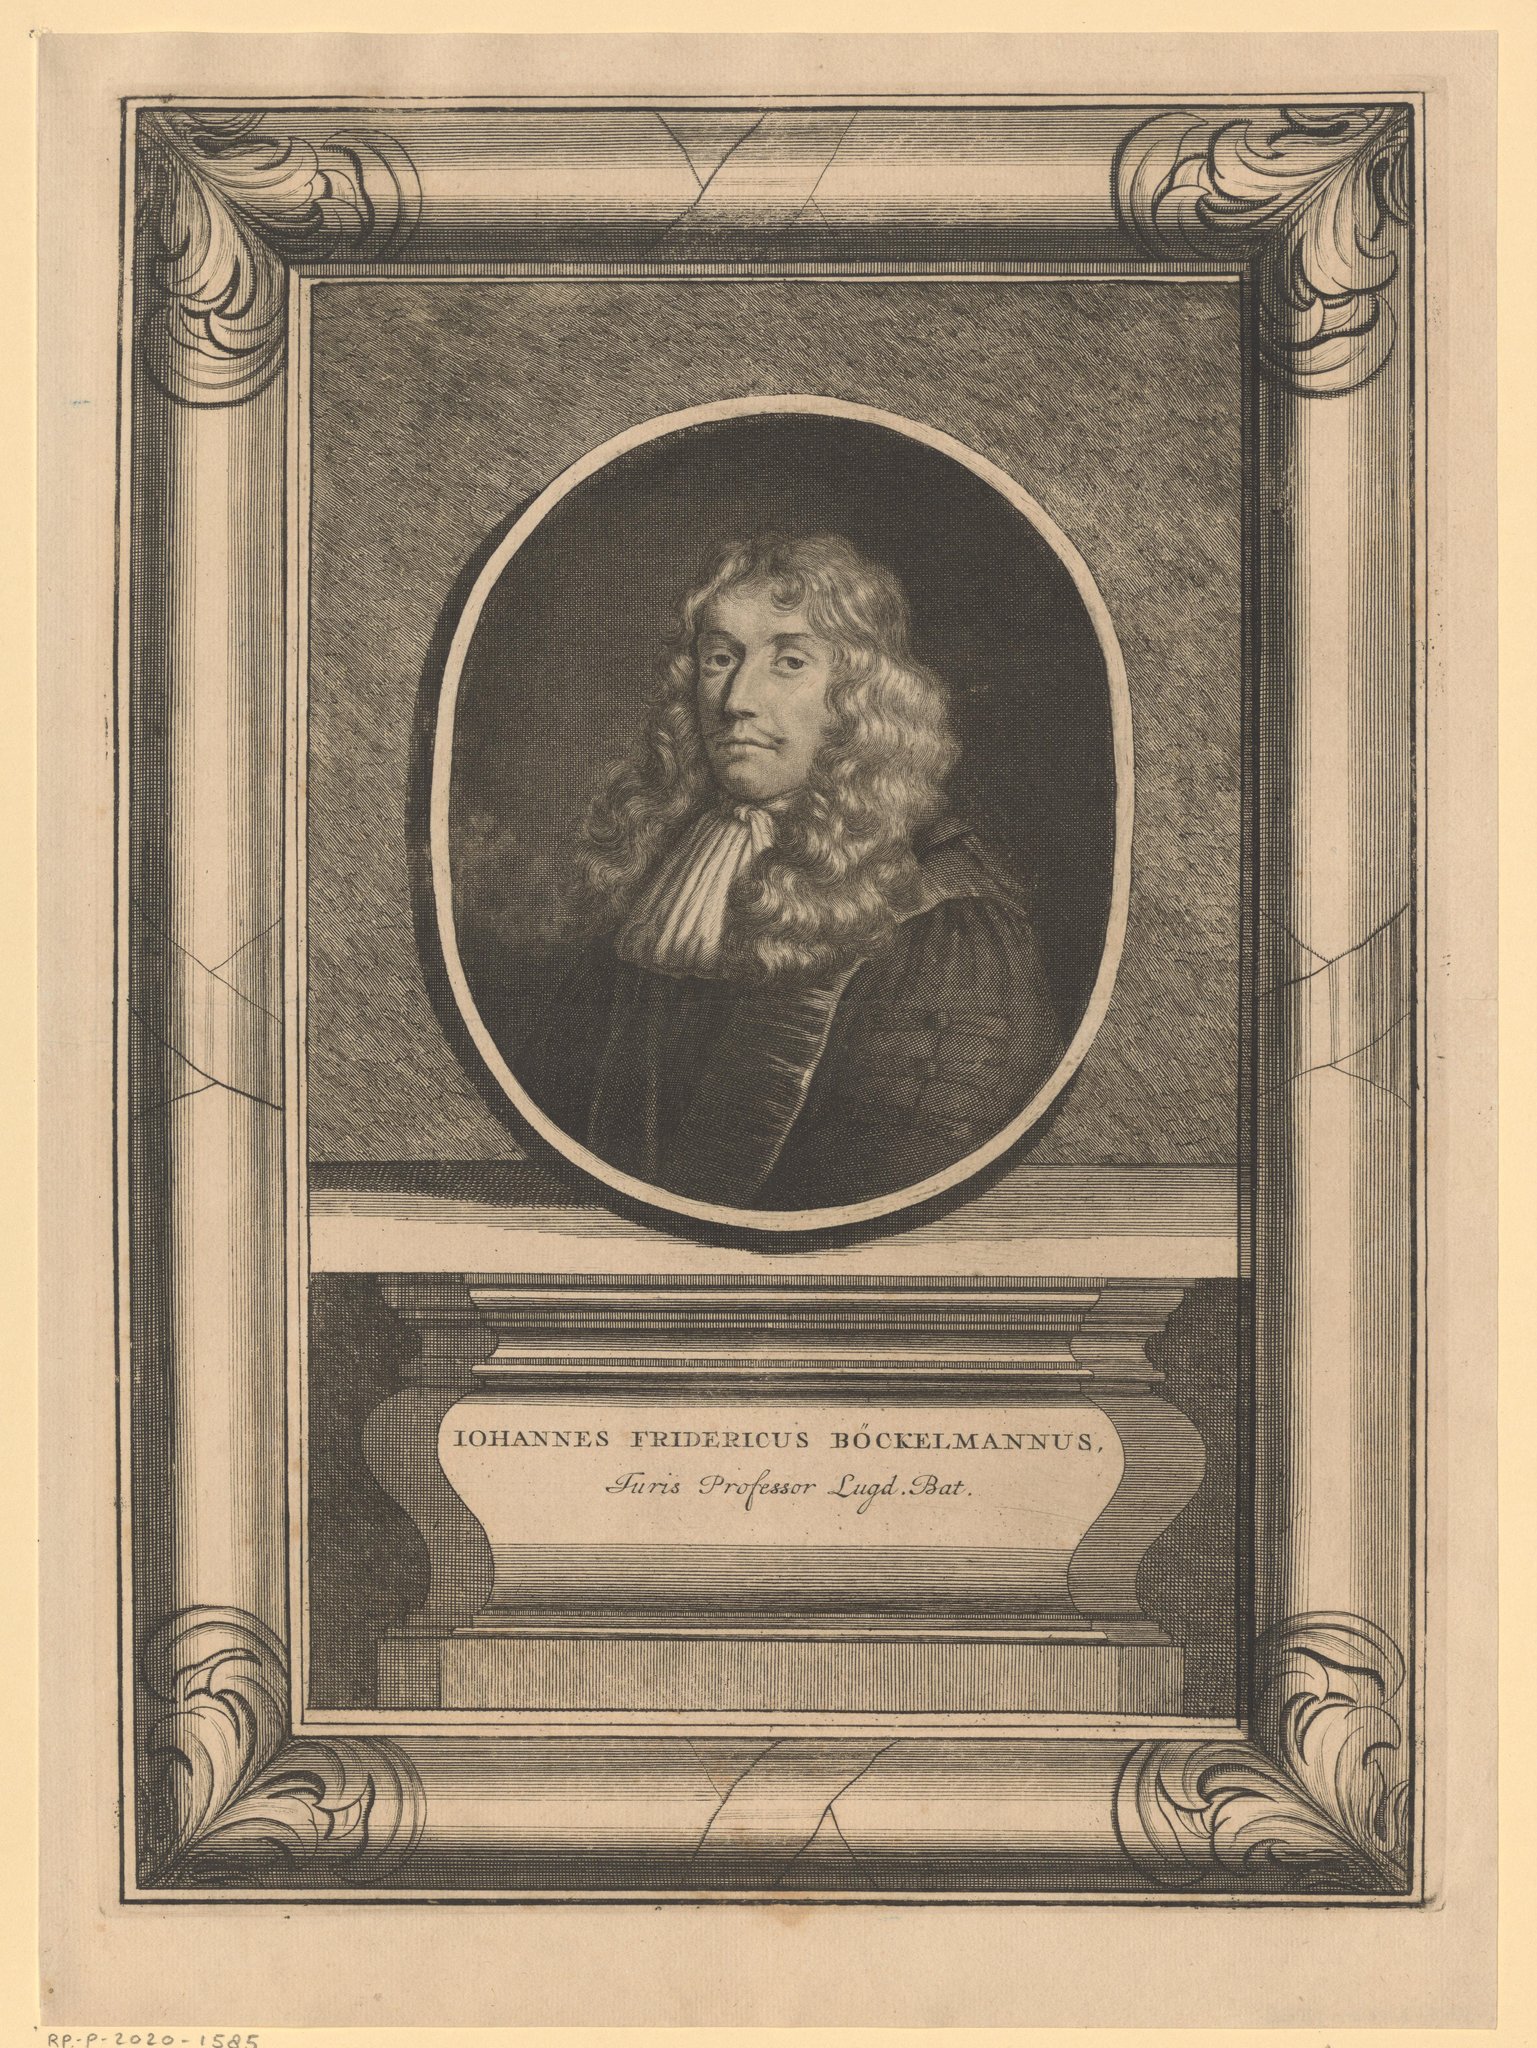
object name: print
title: Portret van Johannes Frederik Bockelman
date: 1700-1730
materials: paper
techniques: engraving, etching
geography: leiden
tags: leiden, historical persons, professor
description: Prent zonder omlijsting gebruikt in: Fundatoris, curatorum et professorum celeberrimorum, aliorumque illustrium virorum, quorum gratia, favore cura, doctrinaque adademia Lugduno-Batava (...). Leiden: Pieter van der Aa, [ca. 1716].